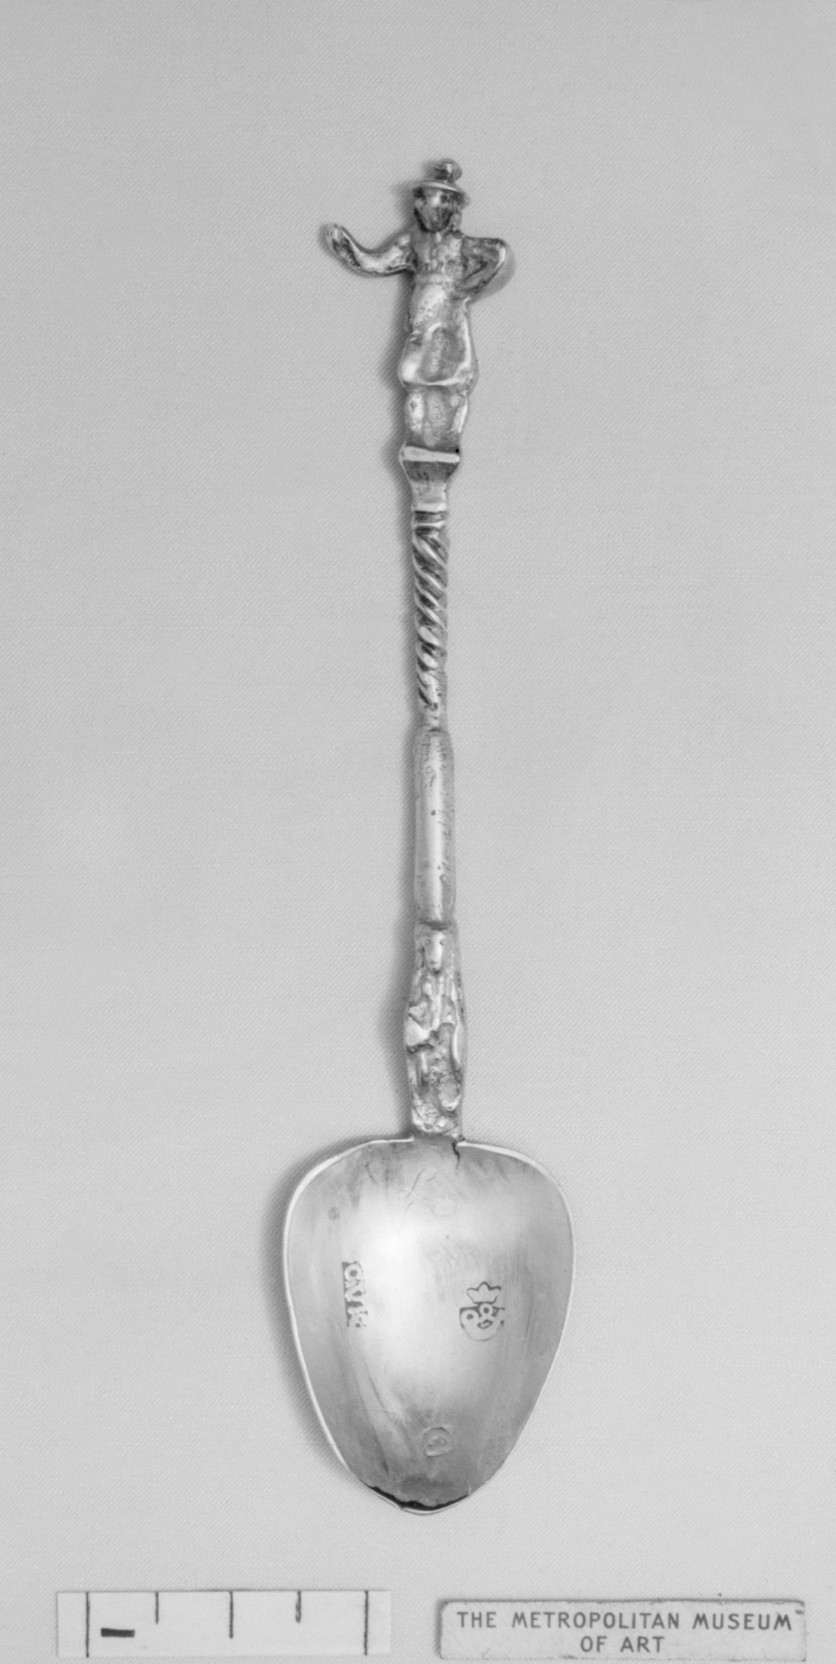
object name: spoon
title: Figure-top spoon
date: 1851-1900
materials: silver